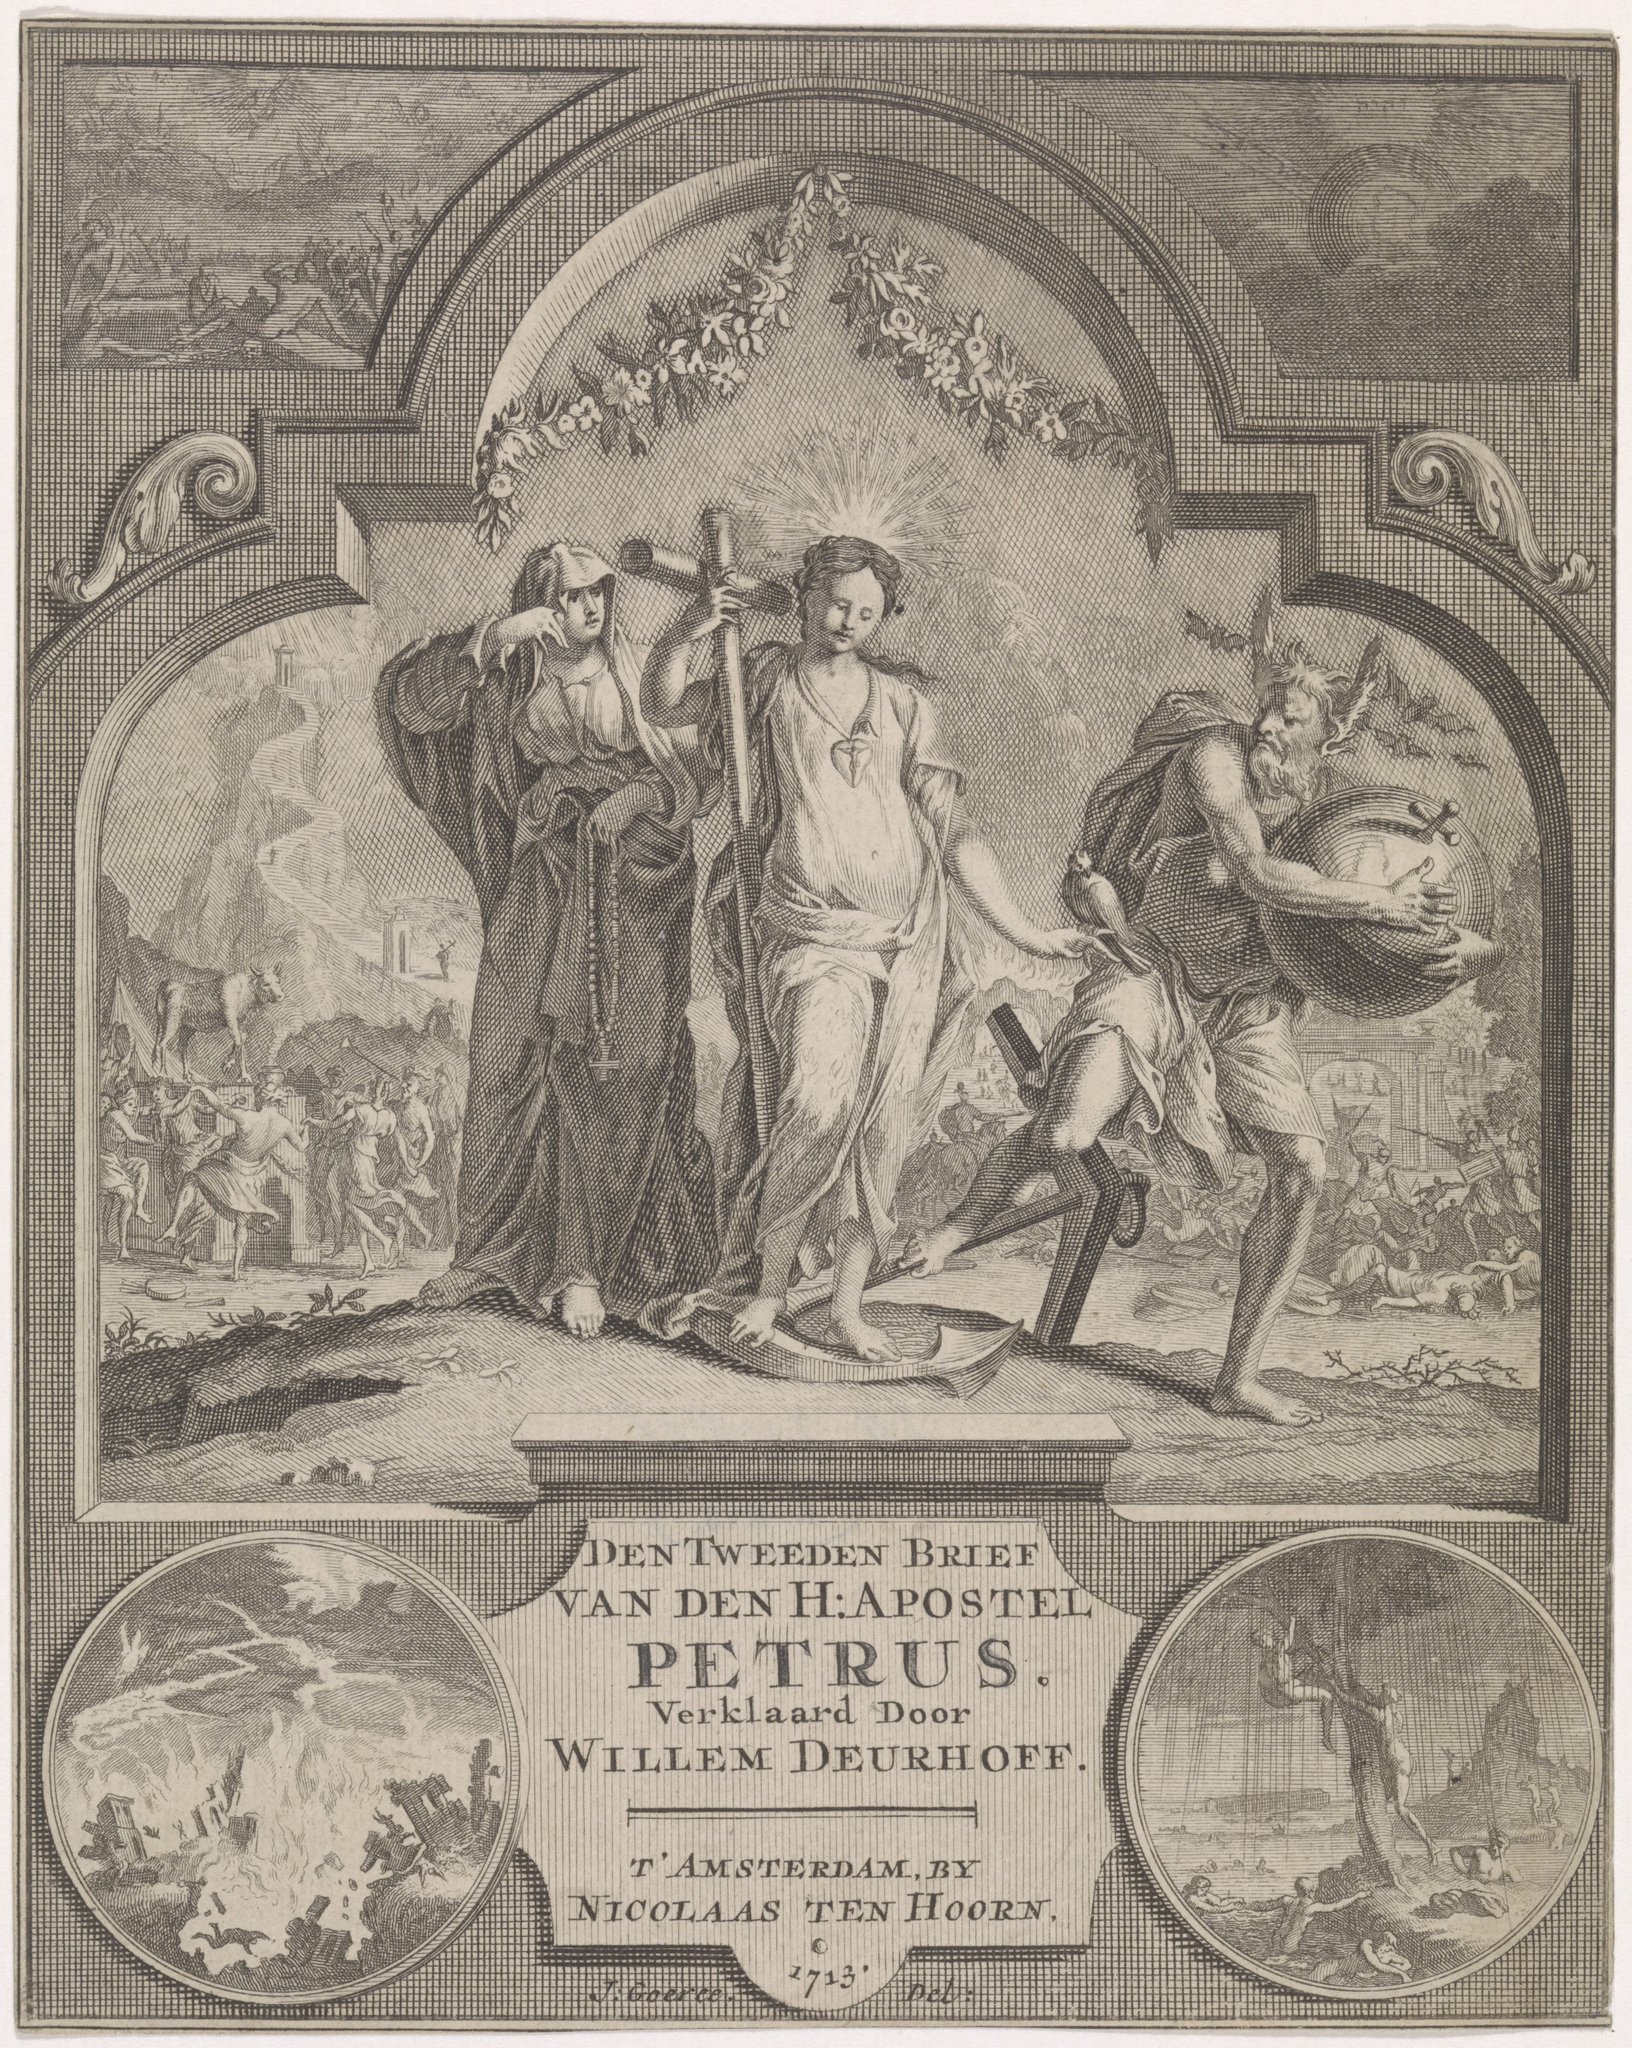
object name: titelblad, titelpagina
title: Titelpagina voor Willem Deurhoff, Geloove, hoope, en liefde der christenen, vertoond in den tweeden brief van den heiligen apostel Simeon Petrus, 1713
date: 1713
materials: paper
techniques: engraving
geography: amsterdam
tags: faith, 'fides'; 'fede', 'fede catholica', 'fede christiana', 'fede christiana catholica' (ripa) ~ one of the three theological virtues, hope, 'spes'; 'speranza divina e certa' (ripa) ~ one of the three theological virtues, the flood and destruction of mankind ~ story of noah (genesis 7:10 - 8:17), adoration of the golden calf (which may be standing on a pillar, and is sometimes depicted as a dragon), last judgement, dream of jacob, with stairway instead of ladder, sodom and gomorrah burning, (story of) midas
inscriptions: collector's mark: Lugt 2228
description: In het midden de personificatie Dwaling, een man met Midasoren. Hij heeft de wereldbol vast en loopt weg van de personificaties Hoop en Geloof. Op de achtergrond scènes van het Oude Testament o.a. de aanbidding van het Gouden Kalf en Jakobs ladder. Onder de voorstelling een cartouche met de titel van het boekwerk. Aan weerszijden van de cartouche een medaillon met een voorstelling uit het Oude Testament. Links de vernietiging van Sodom en rechts de Zondvloed. Boven de voorstelling het Laatste Oordeel.